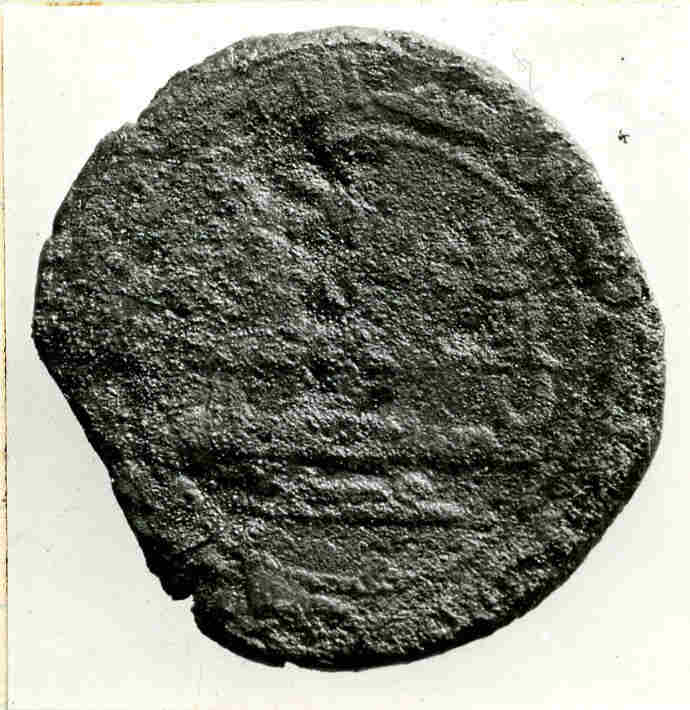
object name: coin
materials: copper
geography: iran